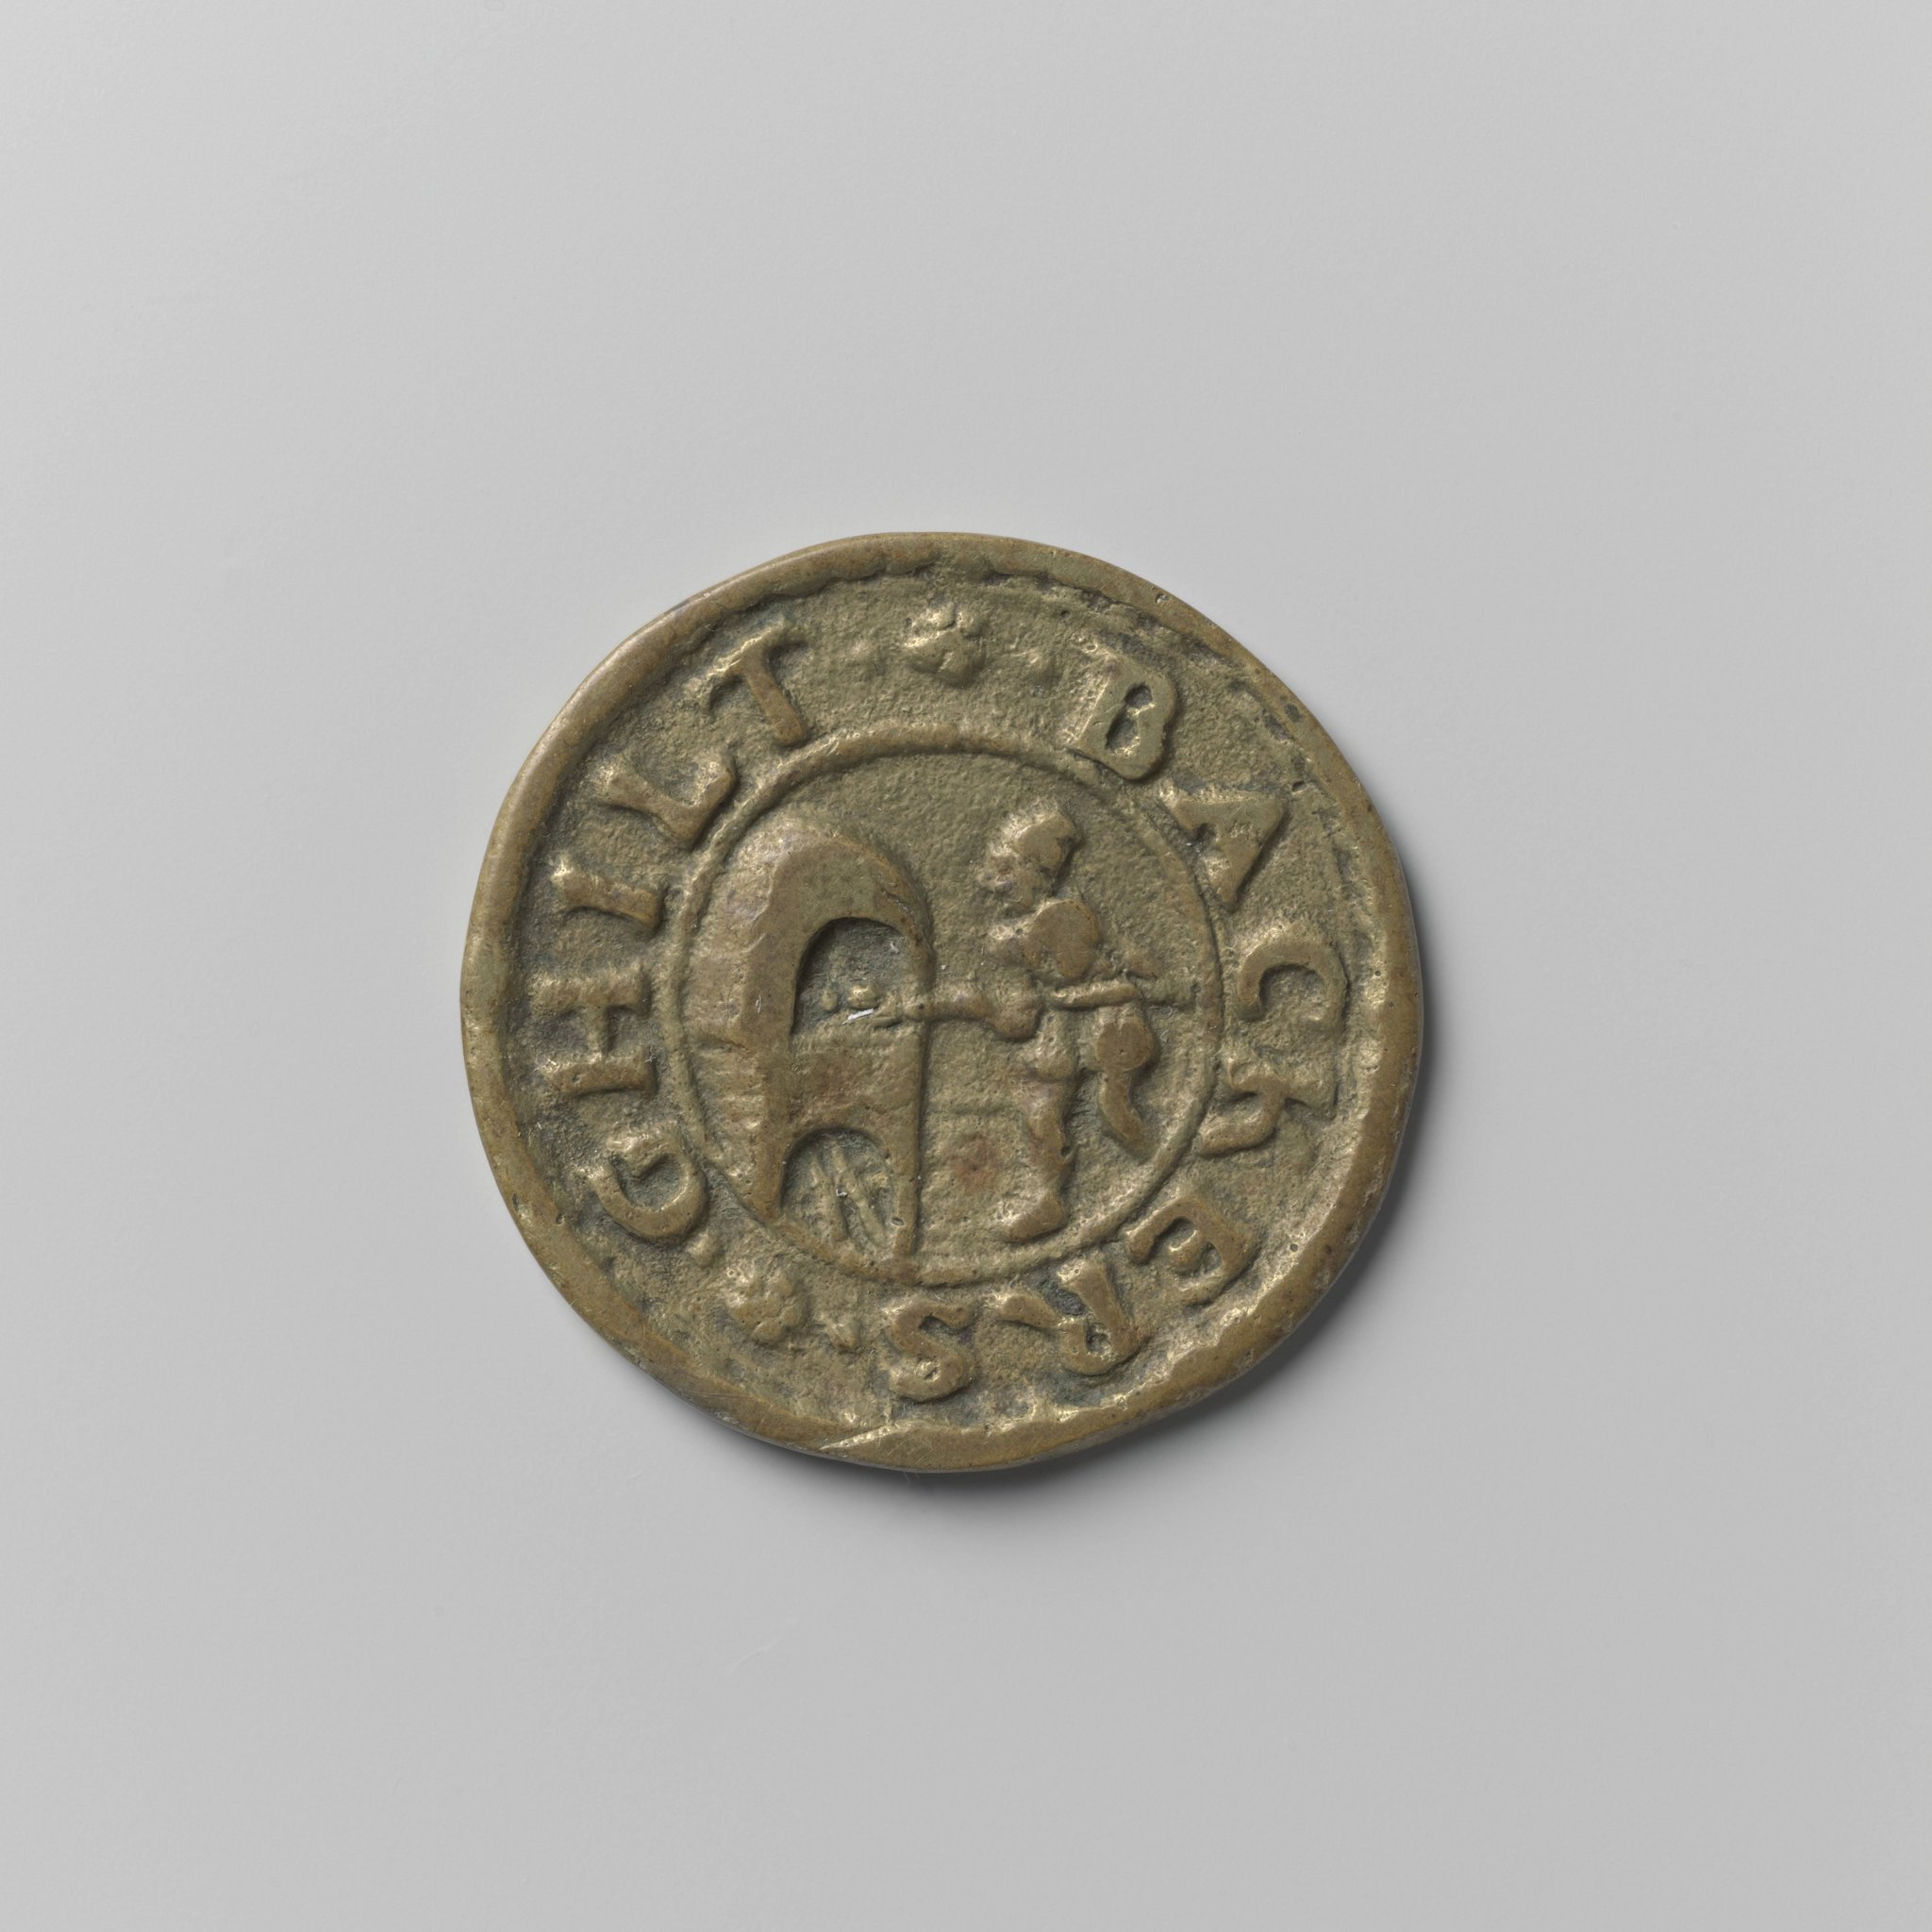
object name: medal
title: Bakkersgilde te Amsterdam, gildepenning van Henderick Woutersen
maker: Anonymous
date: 1652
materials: brass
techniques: casting, engraving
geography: amsterdam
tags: amsterdam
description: Messing penning. Voorzijde: gekroond wapenschild, geflankeerd door twee leuwen; afsnede:opschrift boven letter N. Keerzijde: man, die bezig is om brood in oven te schuiven binnen omschrift